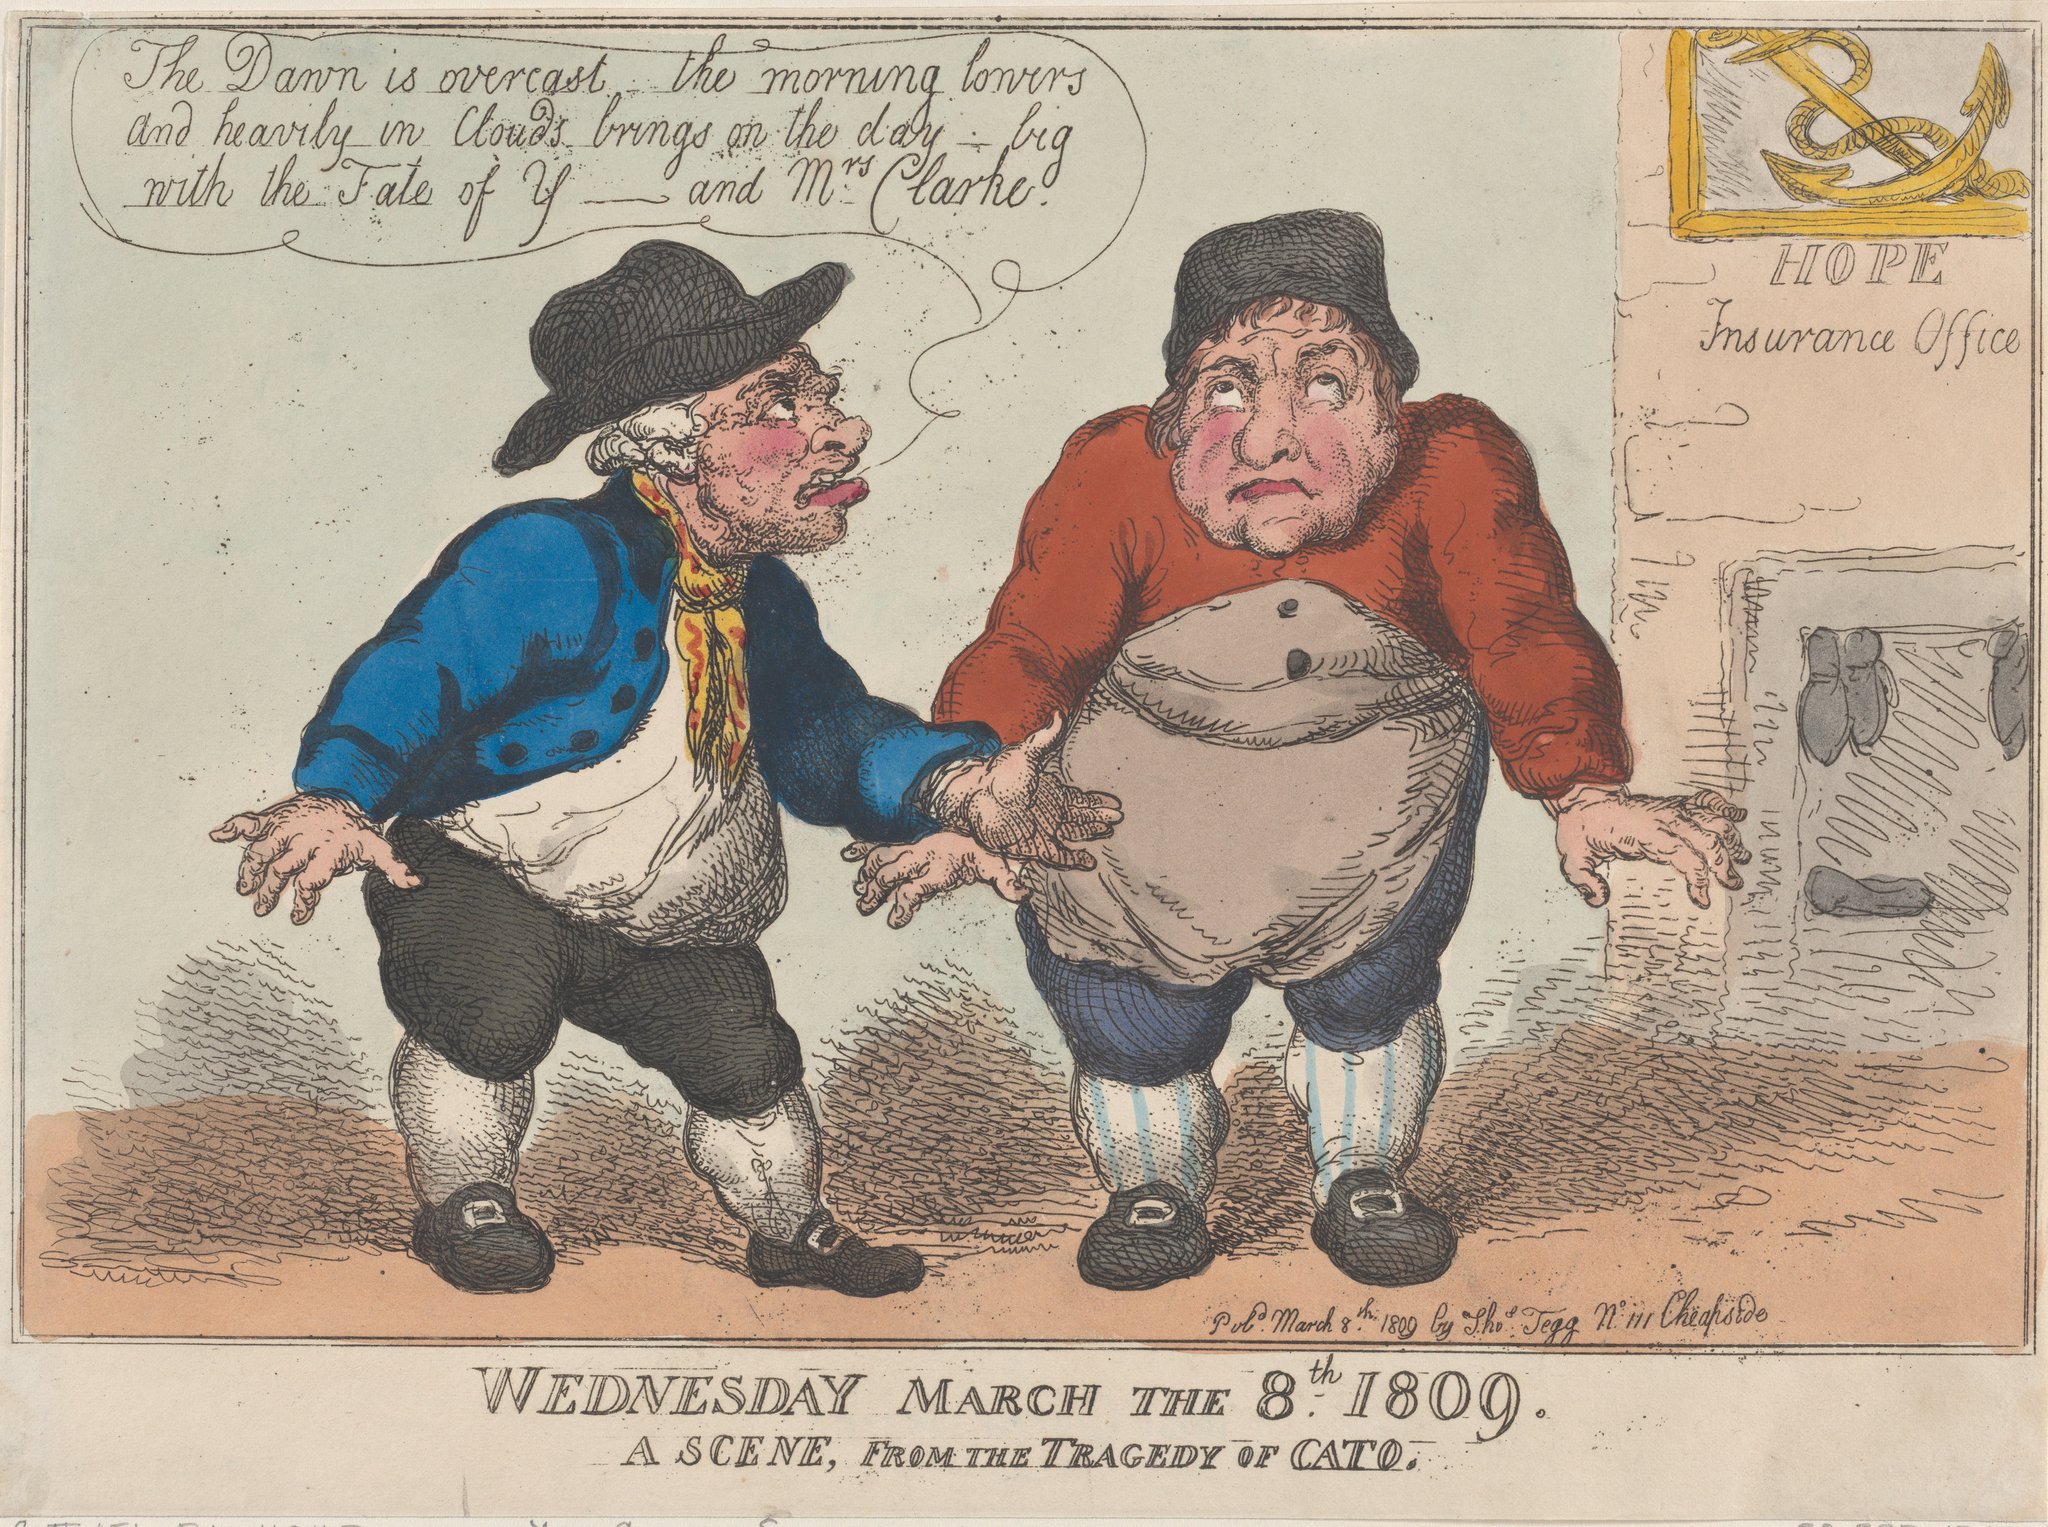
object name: print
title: Wednesday March the 8th 1809, A Scene From The Tragedy of Cato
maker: thomas rowlandson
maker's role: artist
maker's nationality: british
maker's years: 1757-1827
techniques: etching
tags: satire,men